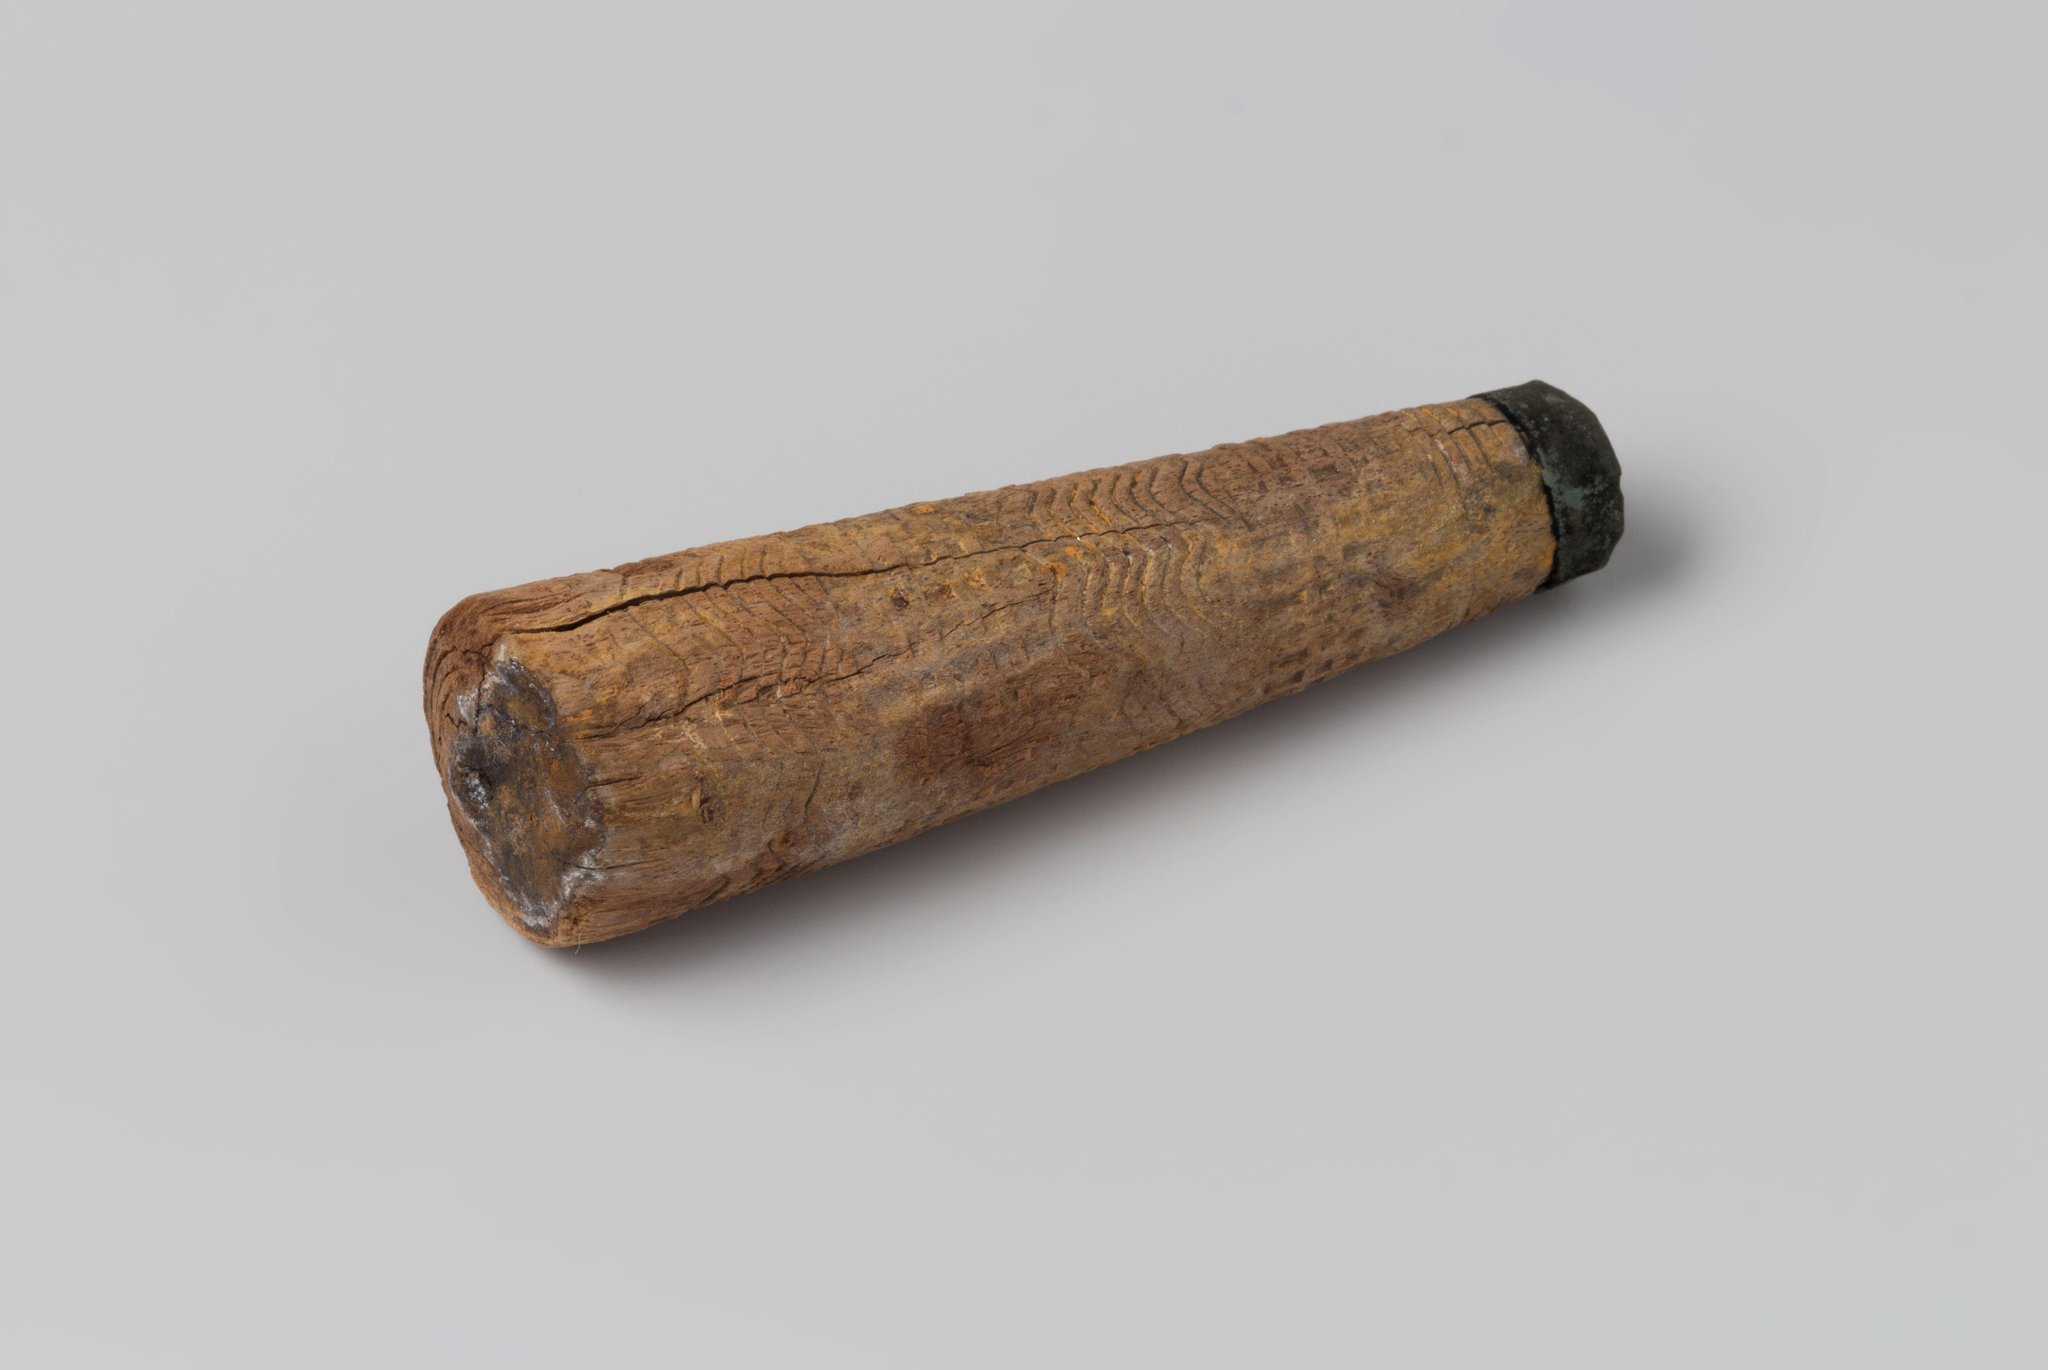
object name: knife handle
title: Messenheft uit het wrak van de Oost-Indiëvaarder Hollandia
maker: Anonymous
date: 1700-1743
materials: copper, wood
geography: netherlands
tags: verenigde oostindische compagnie, hollandia (schip), annet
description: Knife, handle, cylindrical: tapering; id. NG 1979-403H.